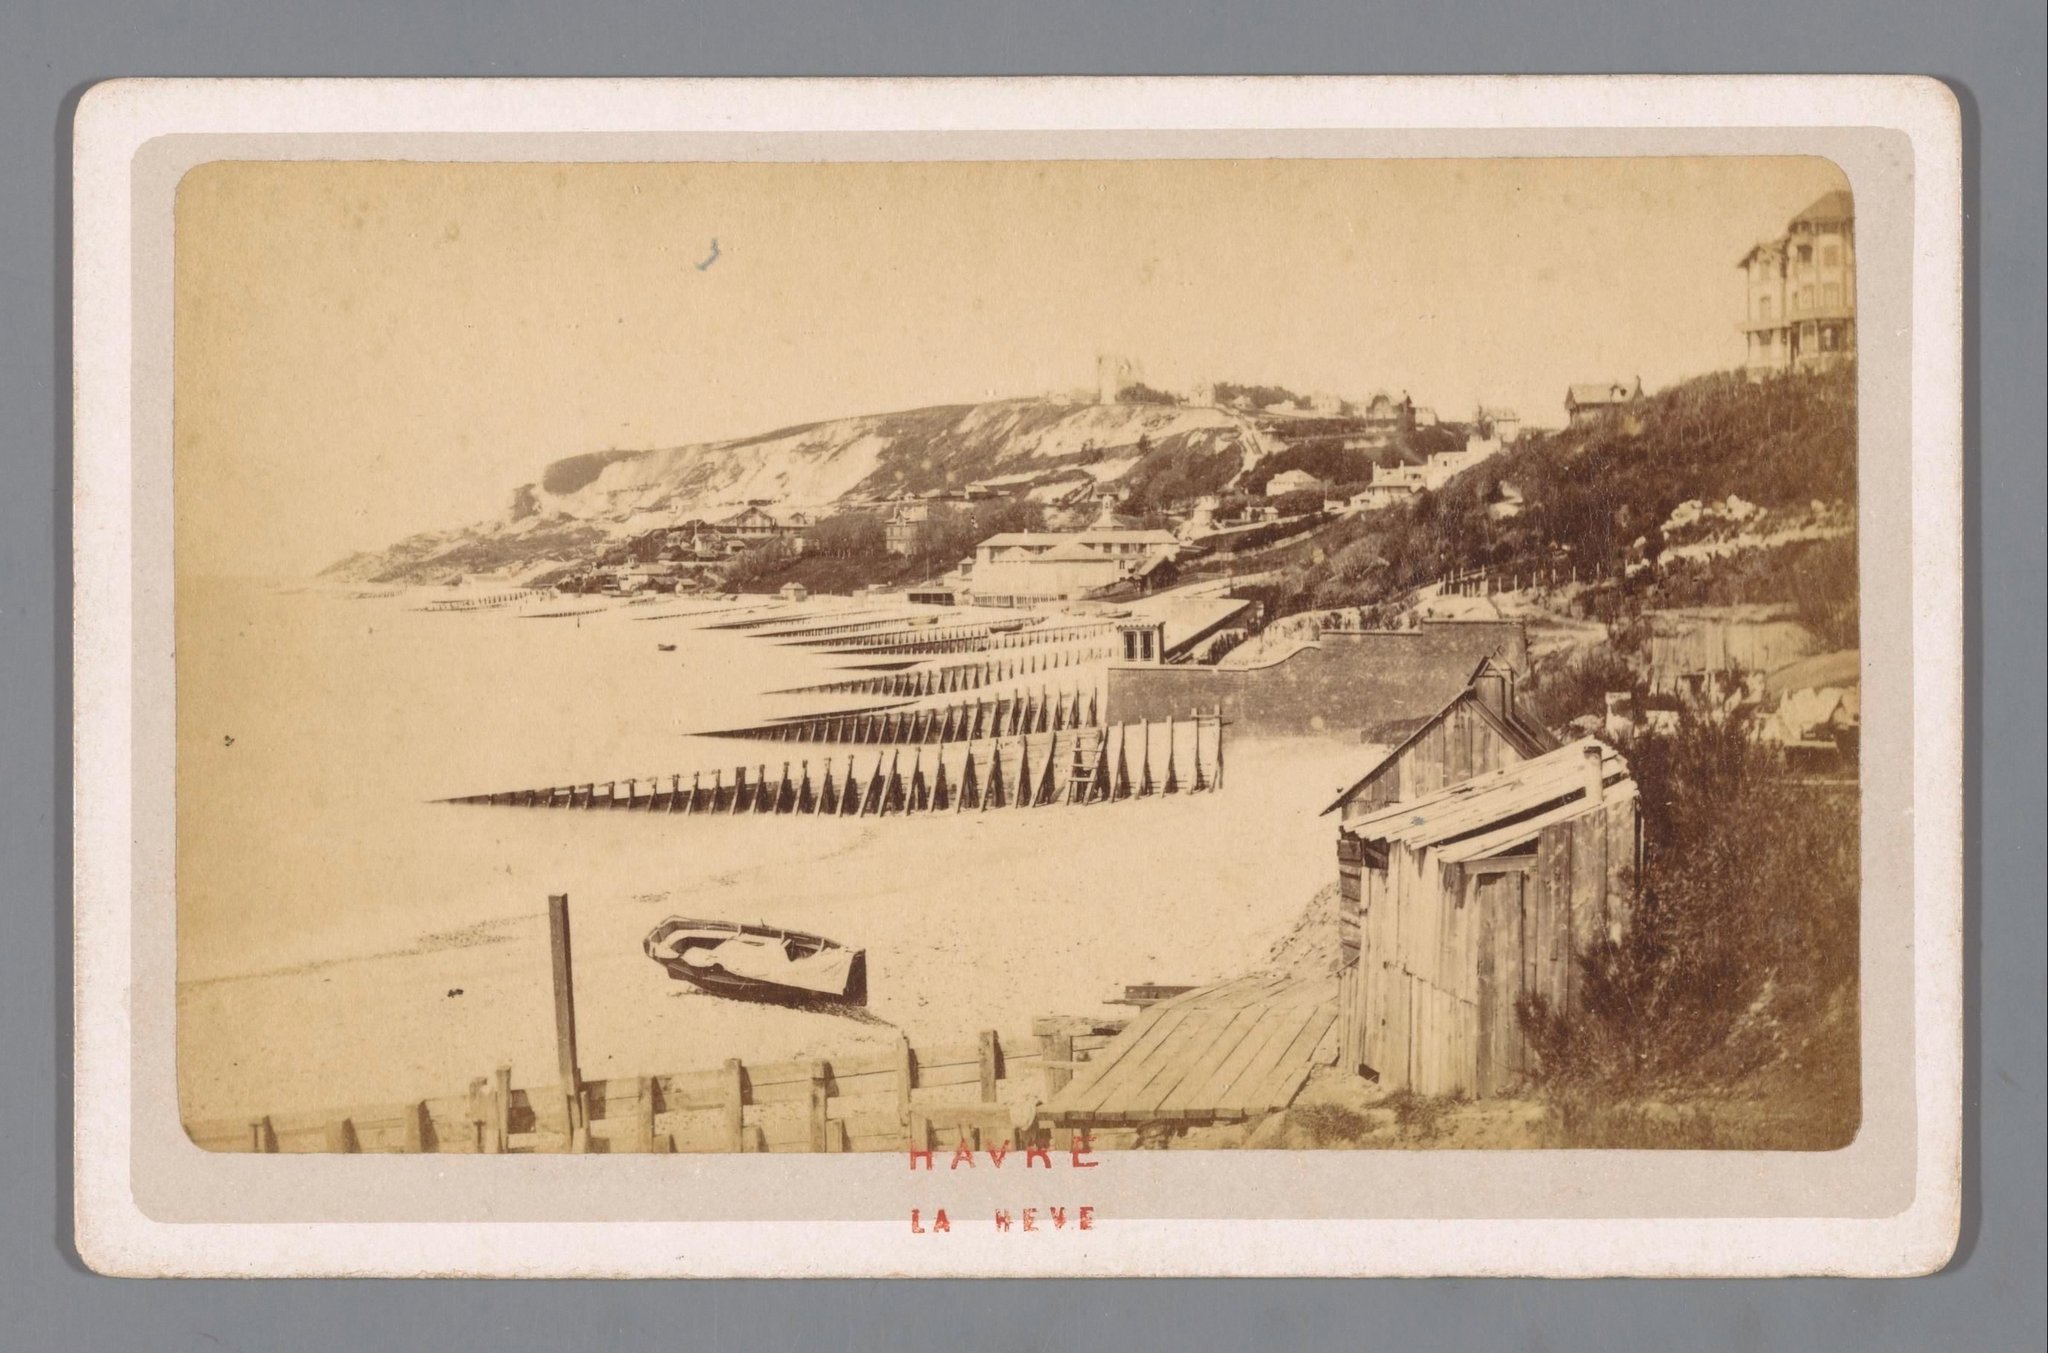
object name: carte de visite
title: Gezicht op de kust bij Le Havre, Frankrijk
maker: Anonymous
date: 1860-1880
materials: paper, photographic support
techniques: albumen print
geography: france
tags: le havre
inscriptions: annotation: ‘HAVRE / LA HEVE [?]’